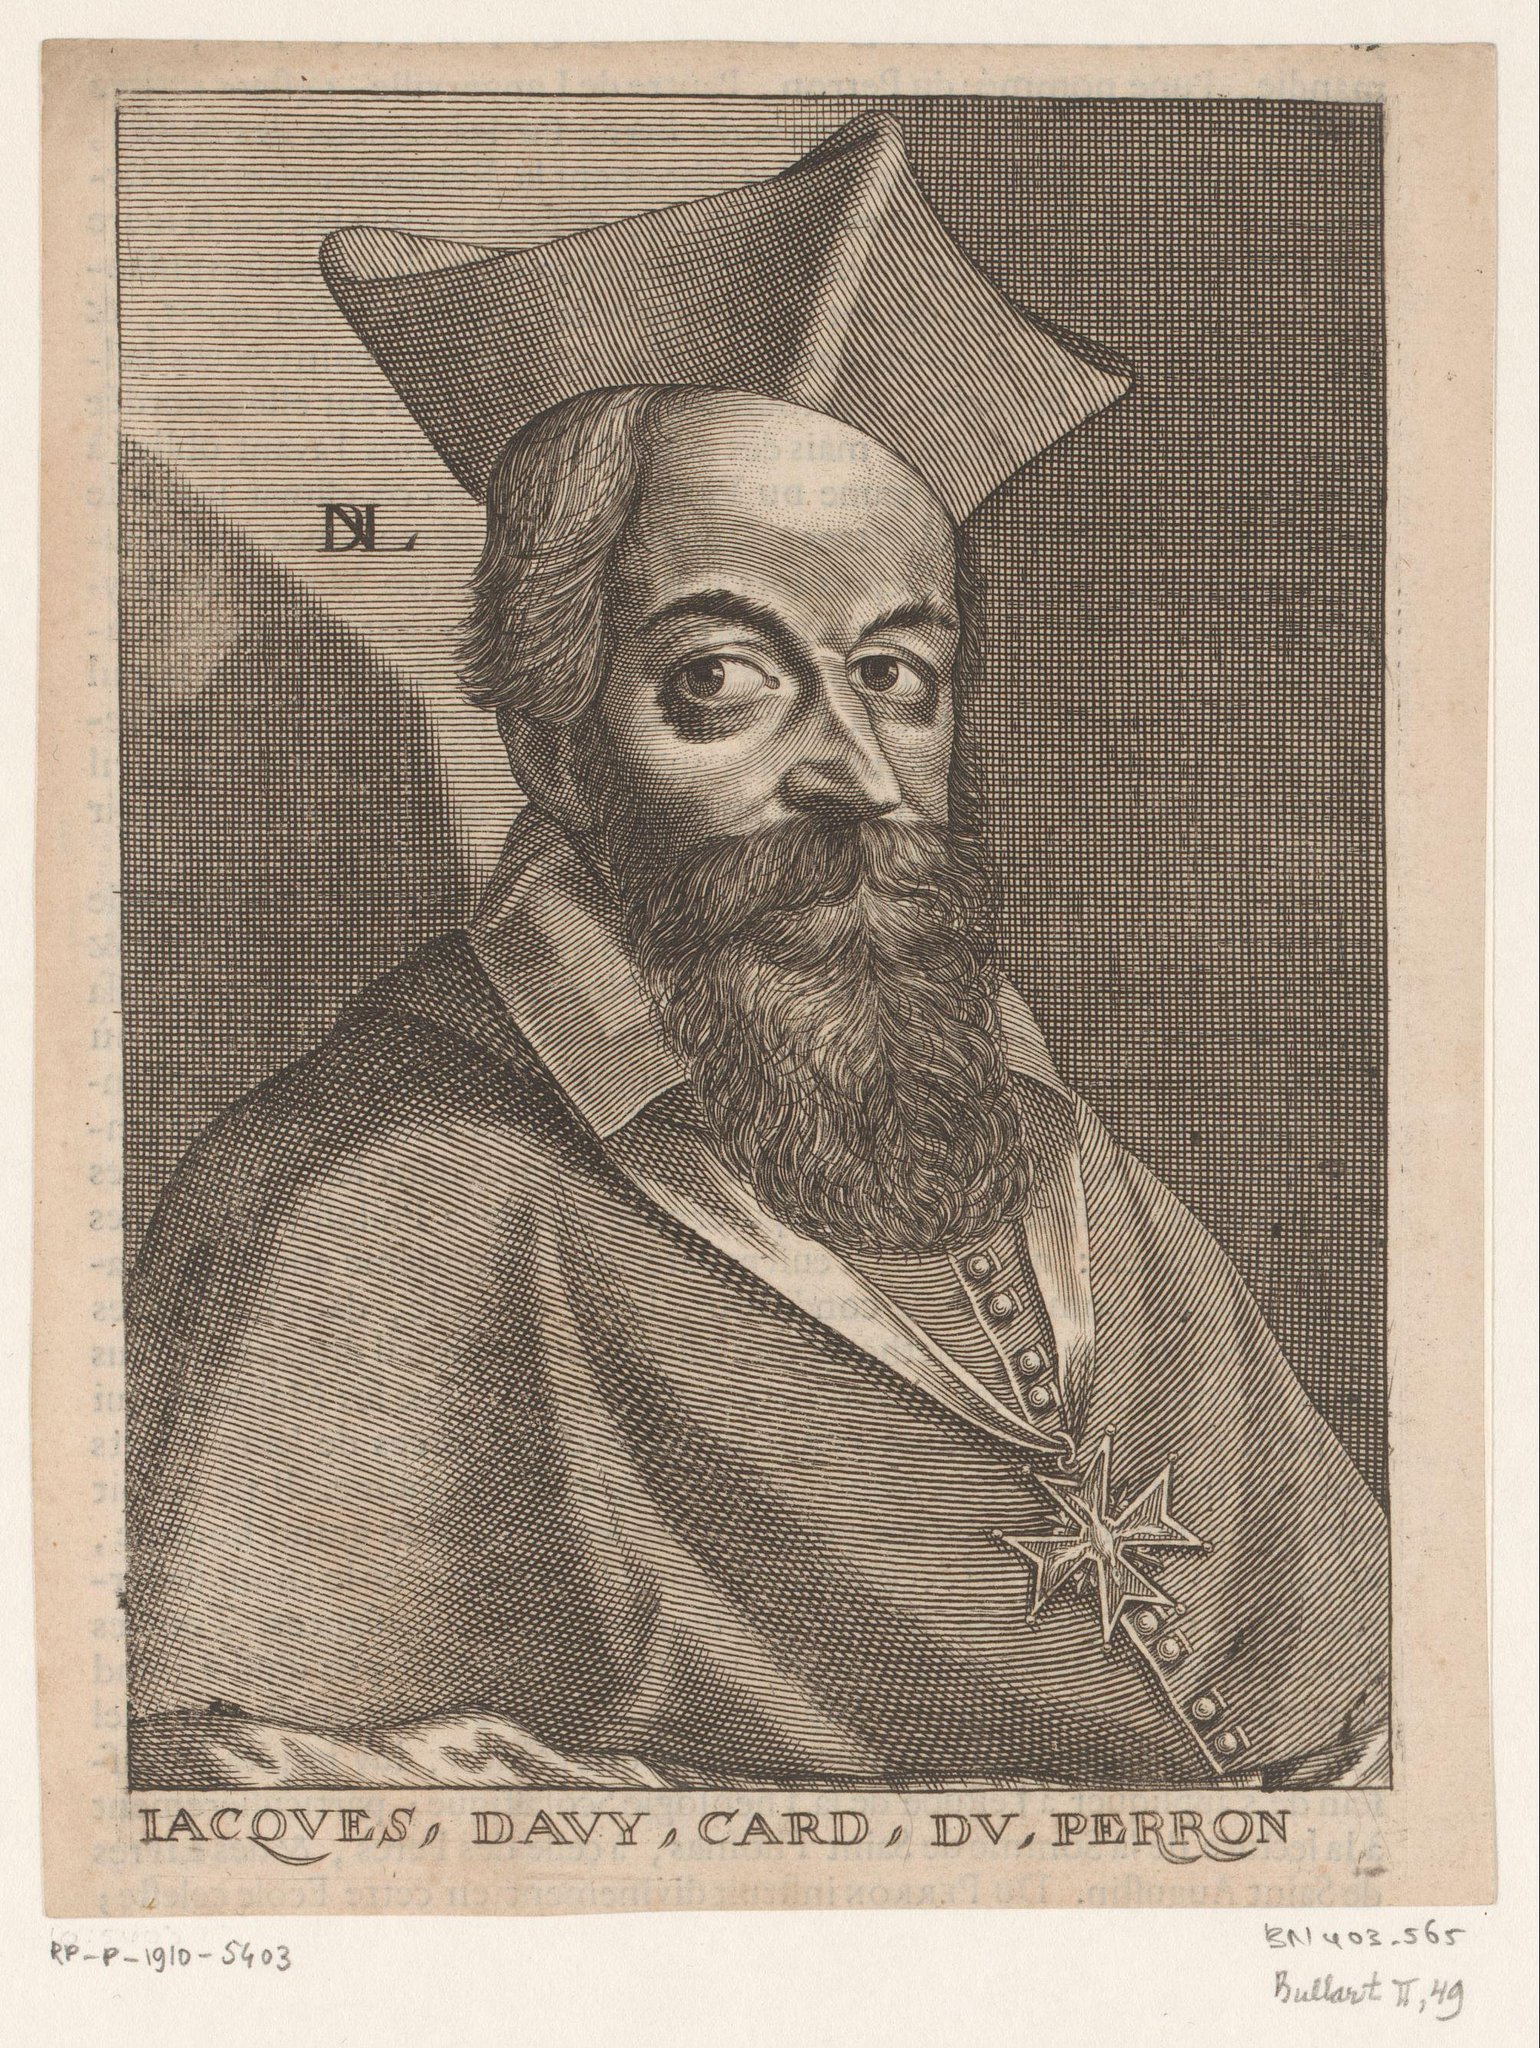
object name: book illustration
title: Portret van Jacques Davy Duperron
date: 1682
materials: paper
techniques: engraving, letterpress printing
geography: brussels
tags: paris, priest, archbishop, bishop, etc. (roman catholic), cardinal, historical persons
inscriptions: collector's mark: Lugt 2228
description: Prent gebruikt voor: Bullart, Isaac. Académie des Sciences et Arts contenant les vies et éloges his. des hommes illustres qui ont excellé en ces professions depuis environ quatre siècles. Brussel: François Foppens, 1682. Het boek werd in 1682 eveneens in Amsterdam uitgegeven door de erfgenamen van Daniel Elzevier. Ieder portret betreft een illustratie bij de biografie van een kunstenaar of geleerde. De meeste portretten werden door Nicolas de Larmessin vervaardigd (162), 93 door De Boulonois en een derde door ongeïdentificeerde prentmakers. Dit betreft een illustratie op p. 49, deel II.